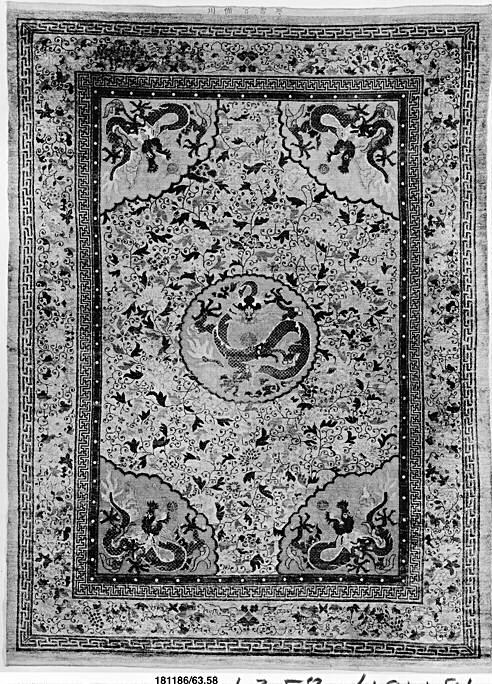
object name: rug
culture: chinese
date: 1801-1900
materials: cotton, metal, silk